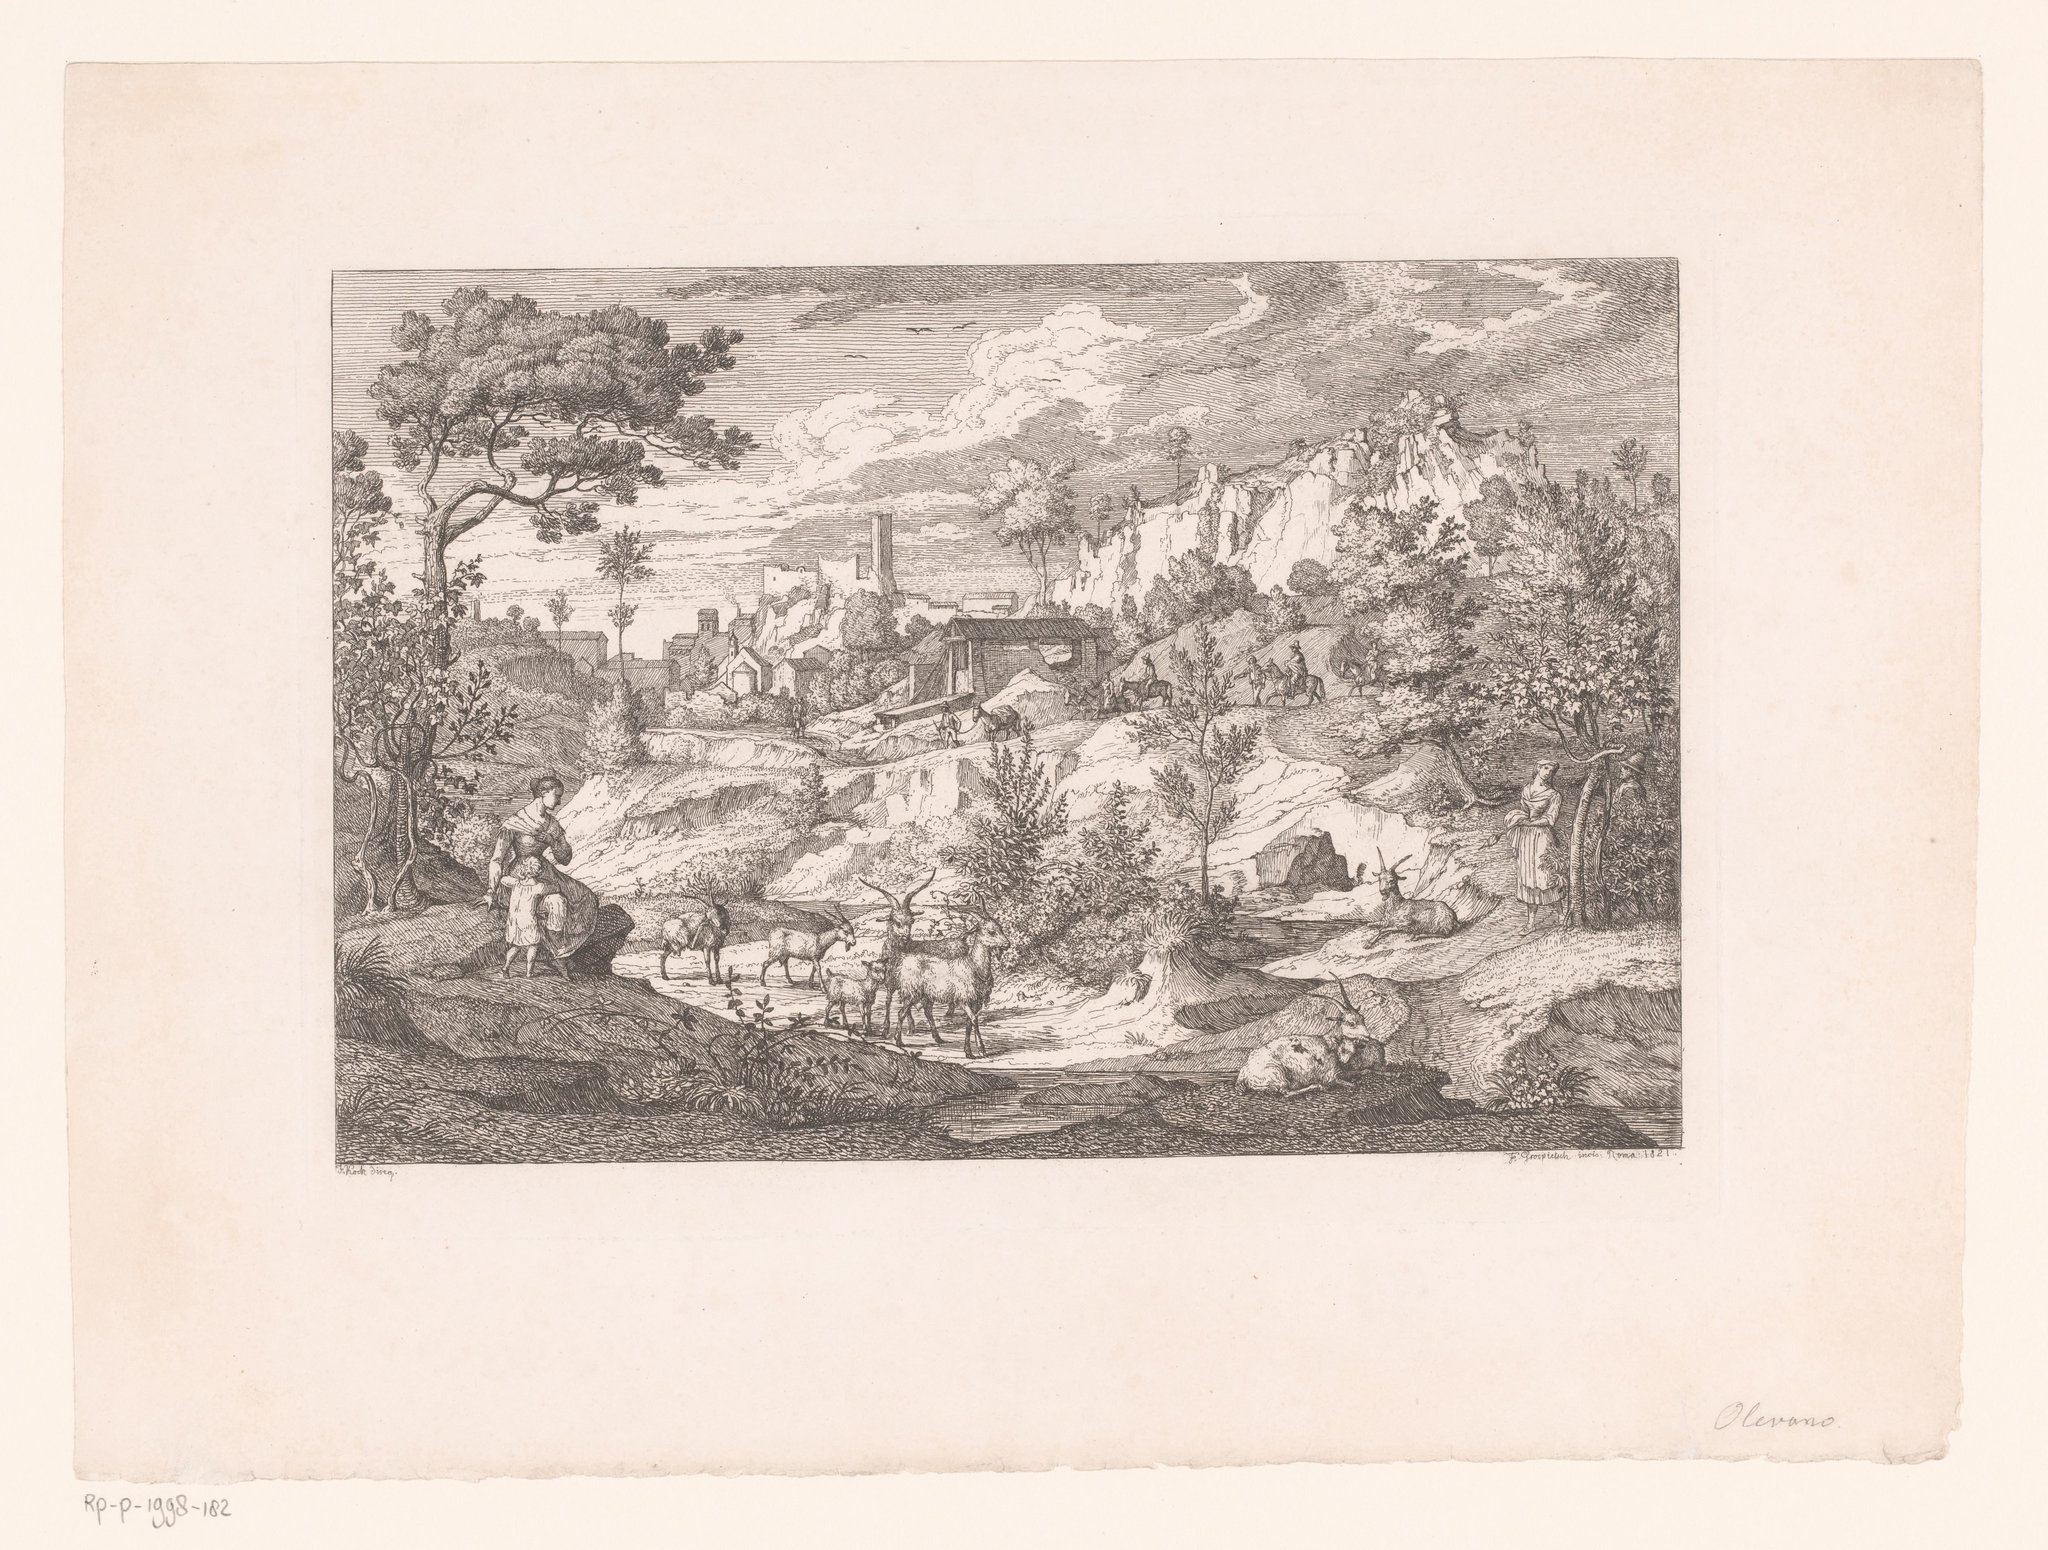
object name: print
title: Landschap bij Olevano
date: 1821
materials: paper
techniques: etching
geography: rome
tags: landscapes, city-view in general; 'veduta', herding, herdsman, herdswoman, shepherd, shepherdess, cowherd, etc., goat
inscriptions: collector's mark: Lugt 2228